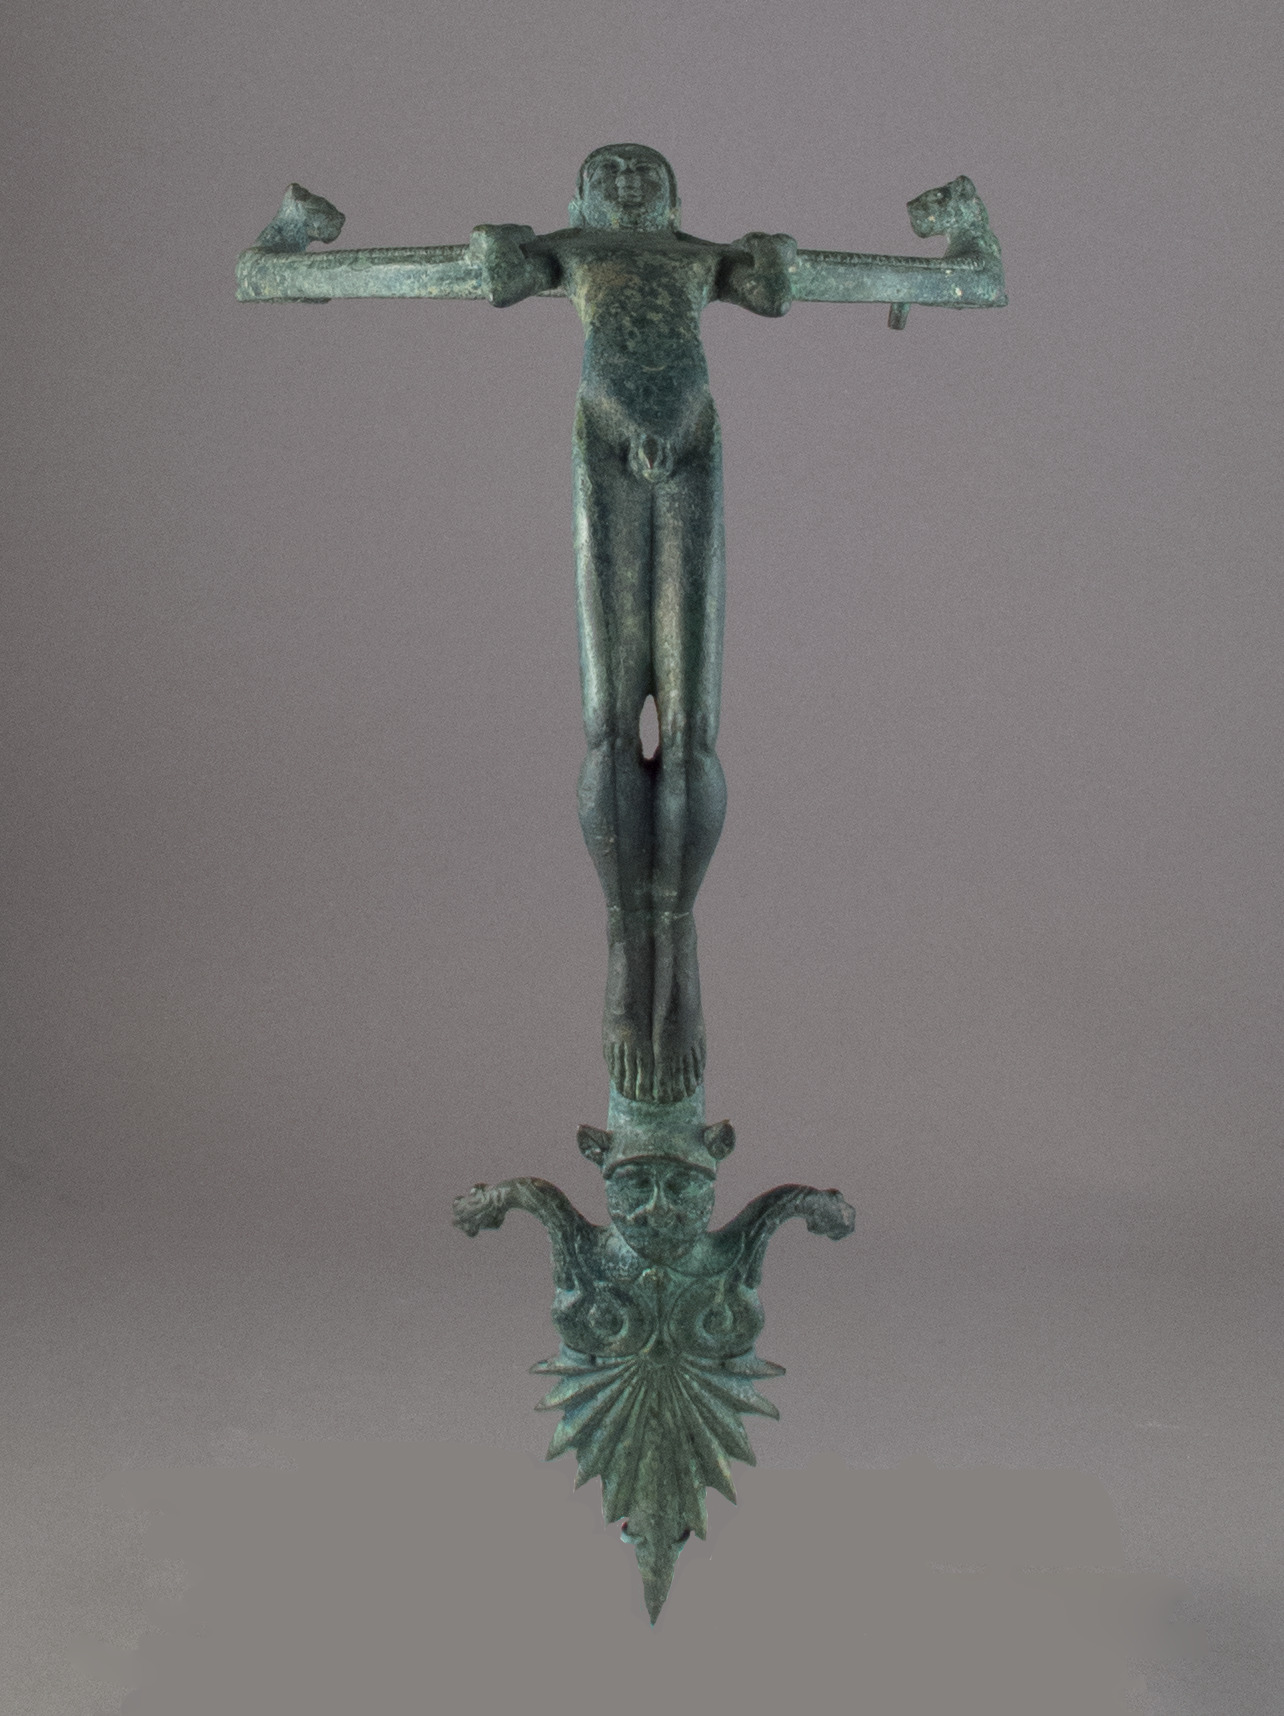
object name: handle and attachment, youth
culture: etruscan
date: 900-100 BCE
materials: bronze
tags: male nudes